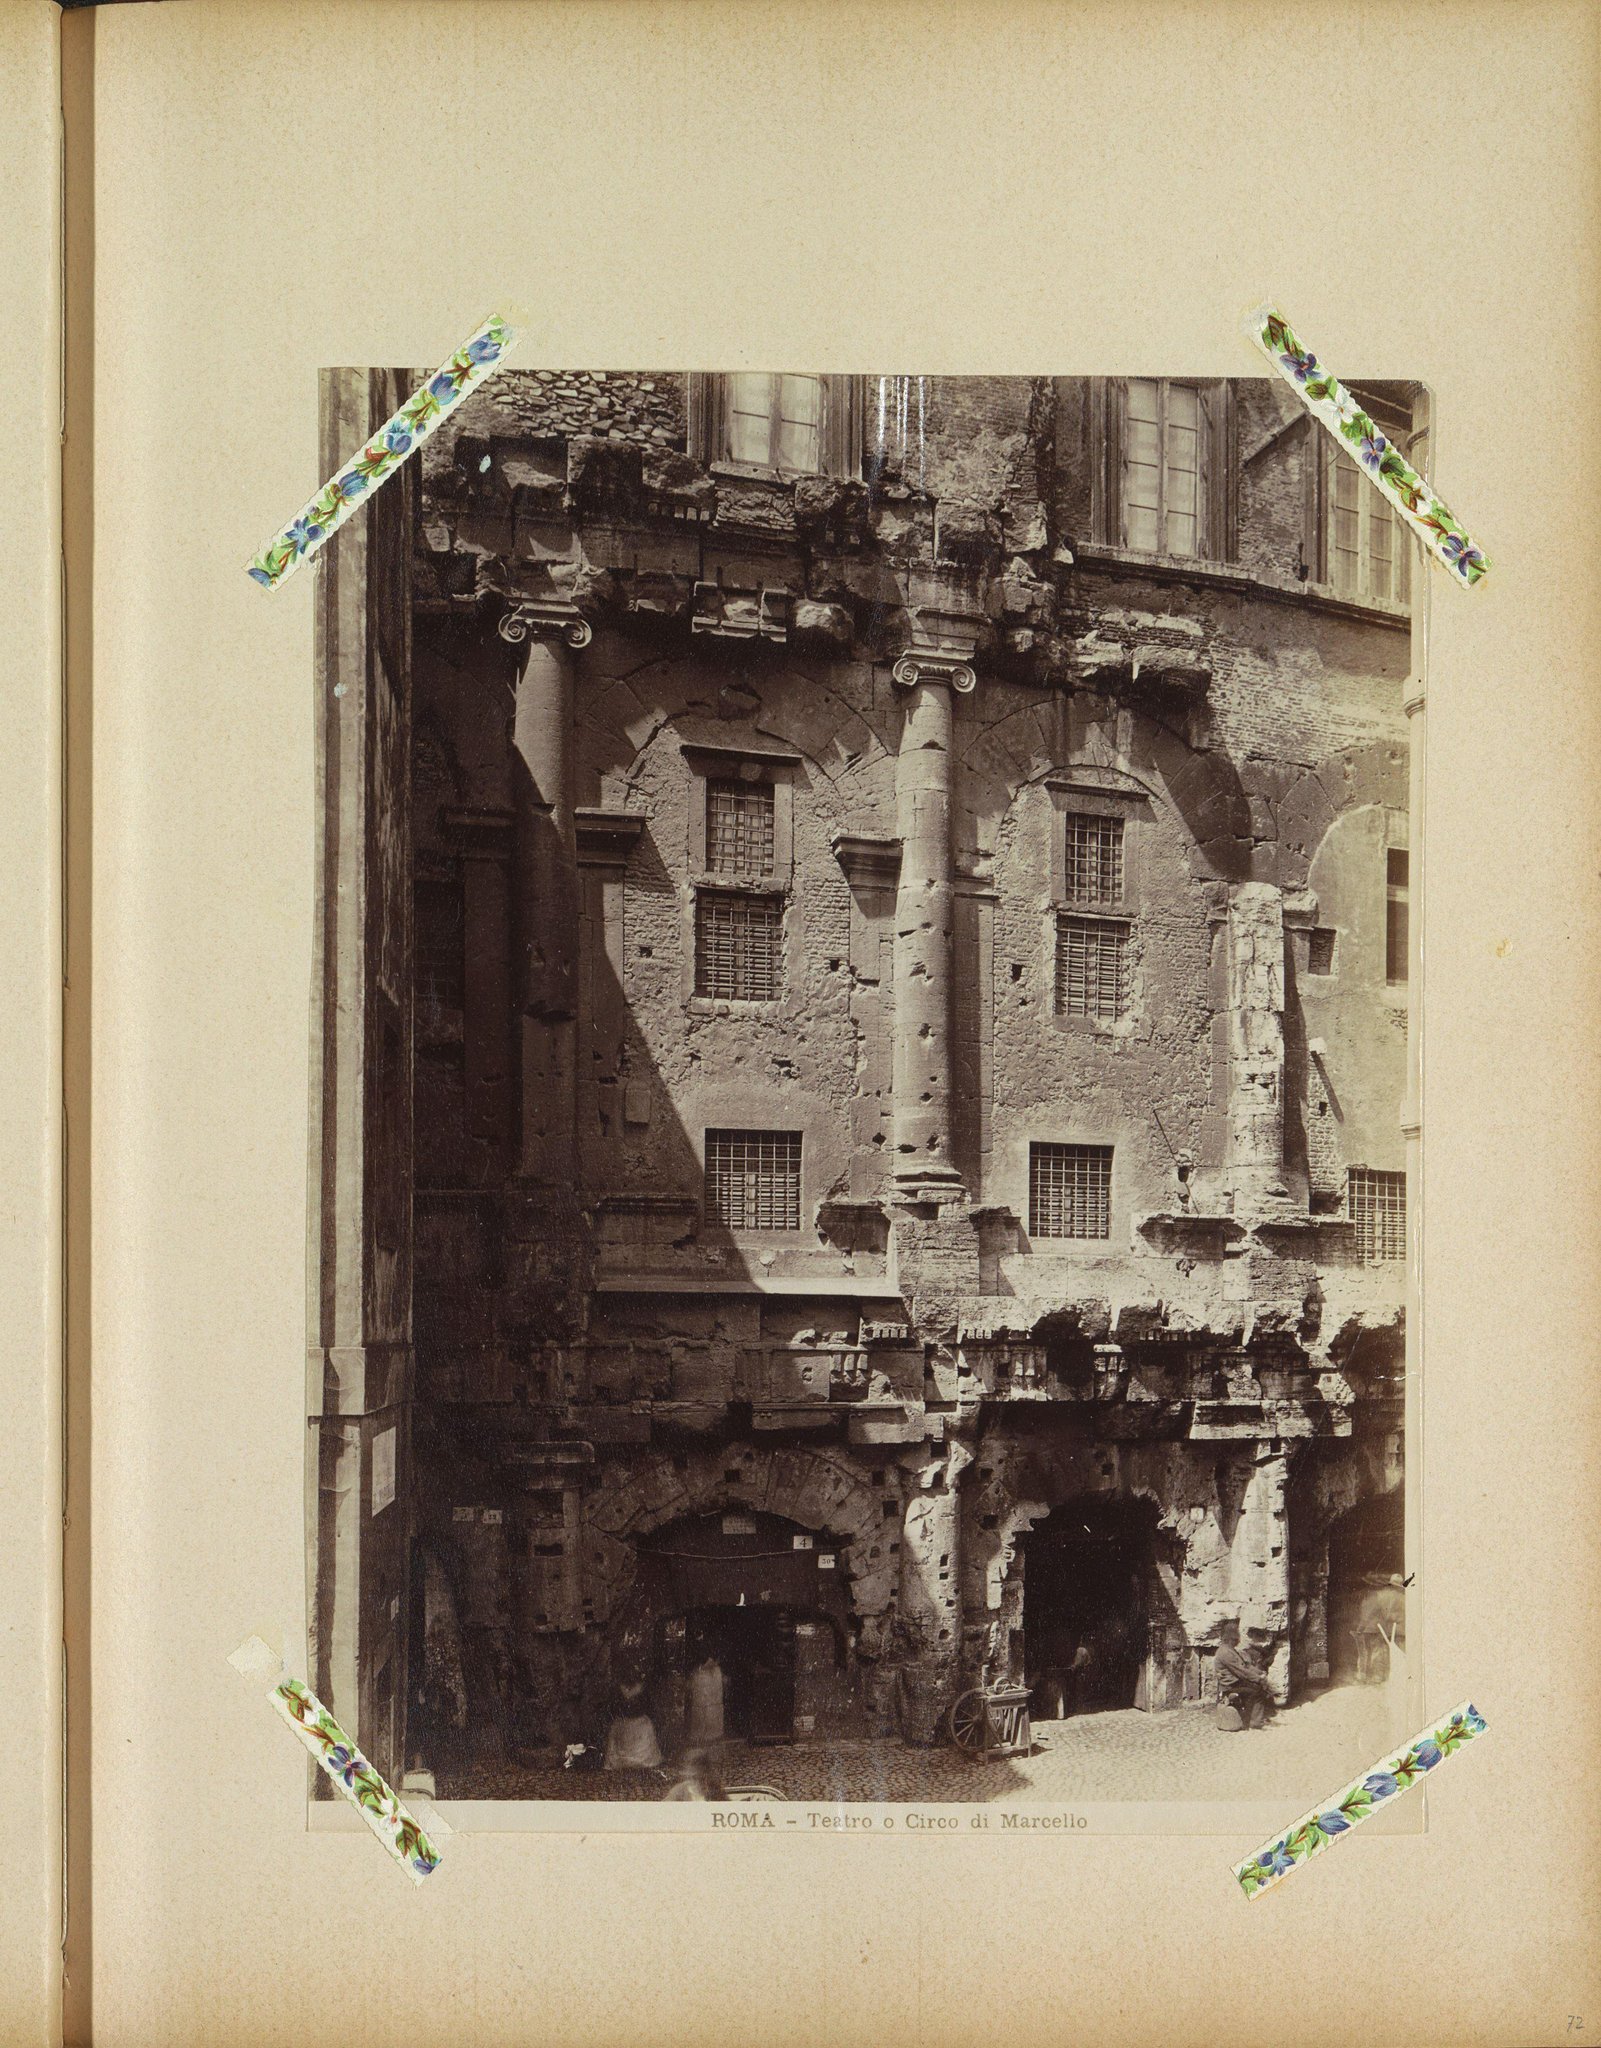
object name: photograph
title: Muren van het Theater van Marcellus aan de Via Sugherari in Rome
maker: Anonymous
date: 1860-1900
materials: photographic support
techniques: albumen print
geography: rome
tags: theatre (building), rome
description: Onderdeel van Fotoalbum met opnames van bezienswaardigheden in Italiaanse steden en van kunstwerken.